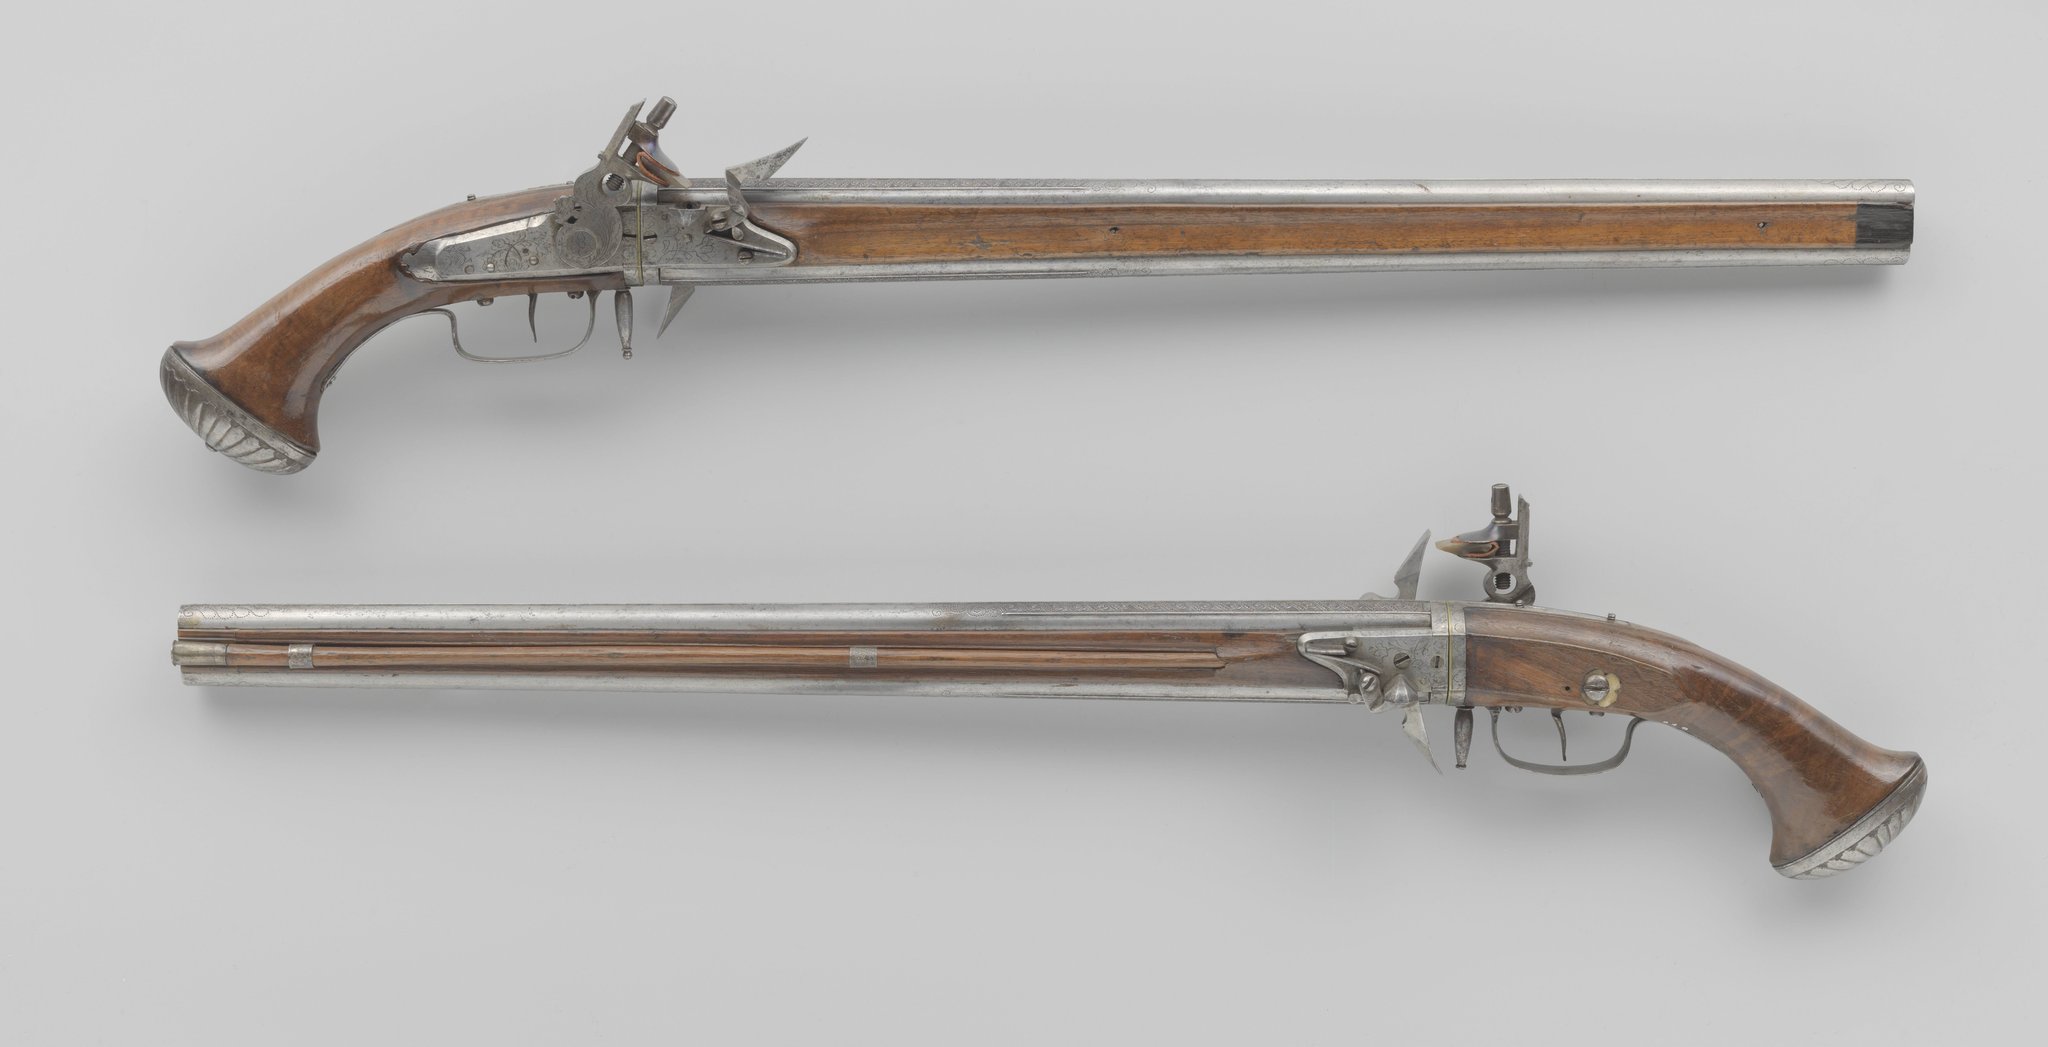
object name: flintlock pistol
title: Dubbelloops vuursteendraailooppistool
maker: Anonymous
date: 1650-1655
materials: horn, iron, silver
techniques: engraving, punching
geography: maastricht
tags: maastricht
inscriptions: mark: ‘CMAL (cf. St. 2259)’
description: Deel van een koppel. Het slot is gedeeltelijk geblauwd; de met bloemenranken gegraveerde slotplaat bestaat uit twee delen en eindigt in de vorm van een monsterkop. De twee boven elkaar gemonteerde lopen zijn versierd met met puntjes ingeslagen guilloches en gebeitelde arabesken en onderop gemerkt met de letters CMAL. De kolf bestaat uit twee delen, de voorlade met groeven, waarvan een plaats biedt aan de laadstokkoker, en de greep met een kelkvormig schroefplaatje erop van koehoorn voor de enkele slotbout. Het beslag bestaat uit twee zilveren laadstokkokers gegraveerd met bloemen, een ijzeren trekkerbeugel met met puntjes ingeslagen ranken, een ijzeren deblokkeringspal om het draailoopmechanisme te ontgrendelen, een ijzeren kolfkap met ribbels en een knopje, en een laadstok voorzien van zilveren kap gegraveerd met een lijnmotief.